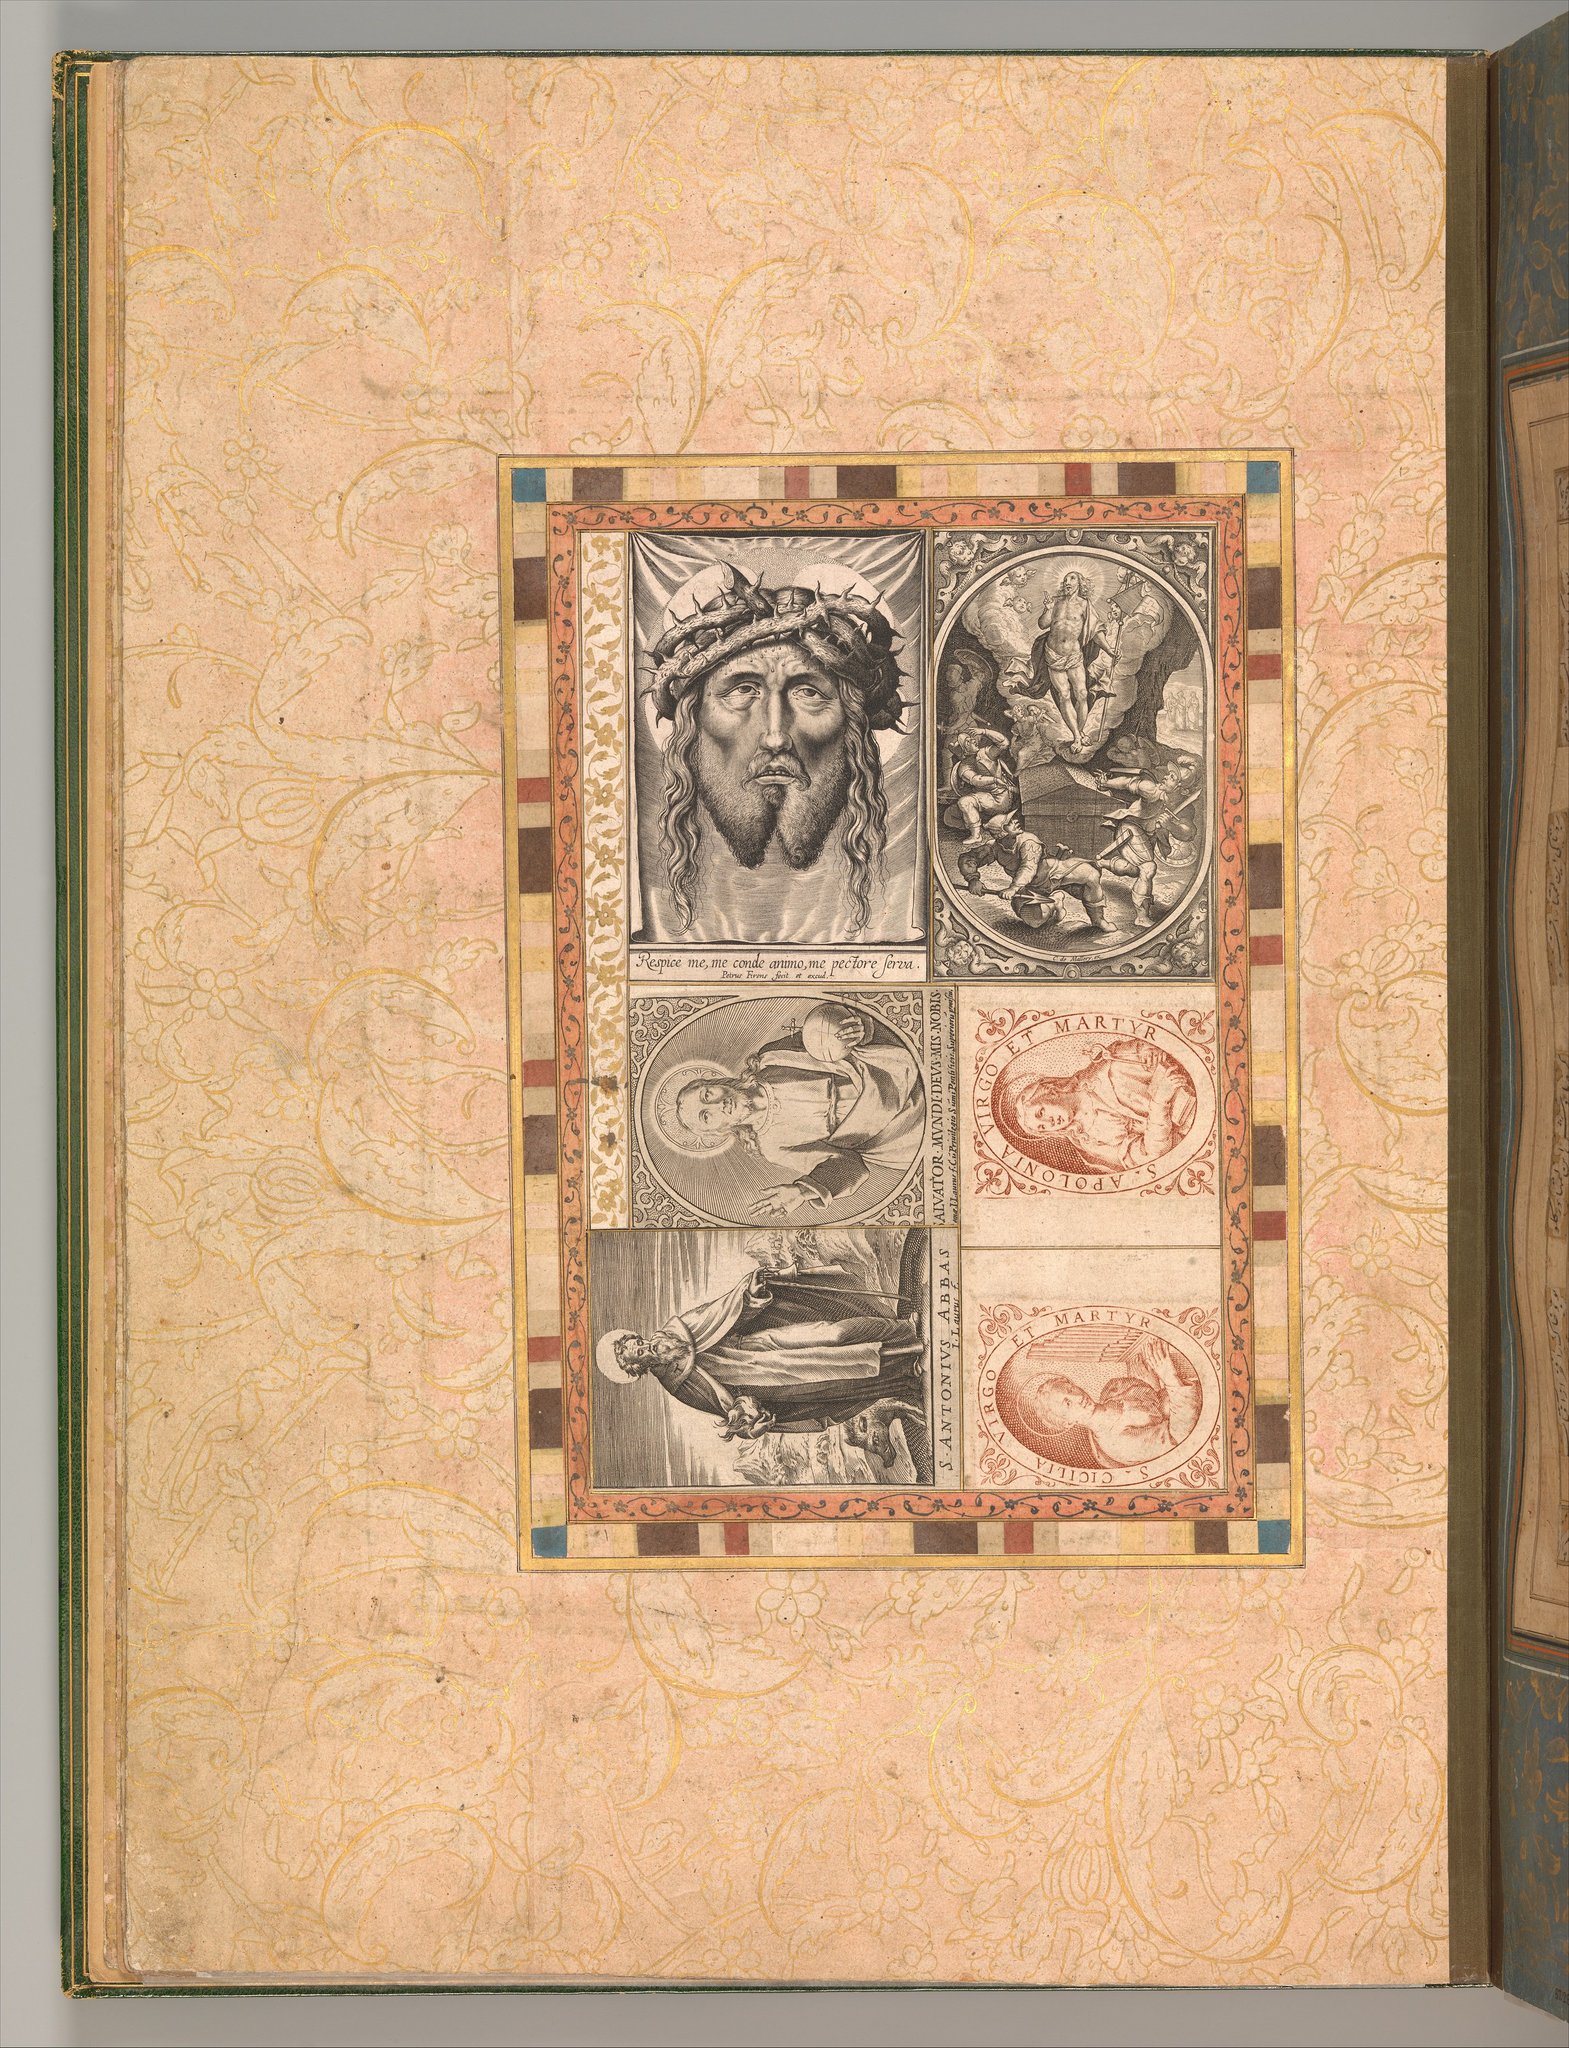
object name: illustrated album leaf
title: "Six Devotional Subjects," Folio from the Bellini Album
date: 1600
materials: gold, ink, paper, watercolor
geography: italy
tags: men,women,christ,saints